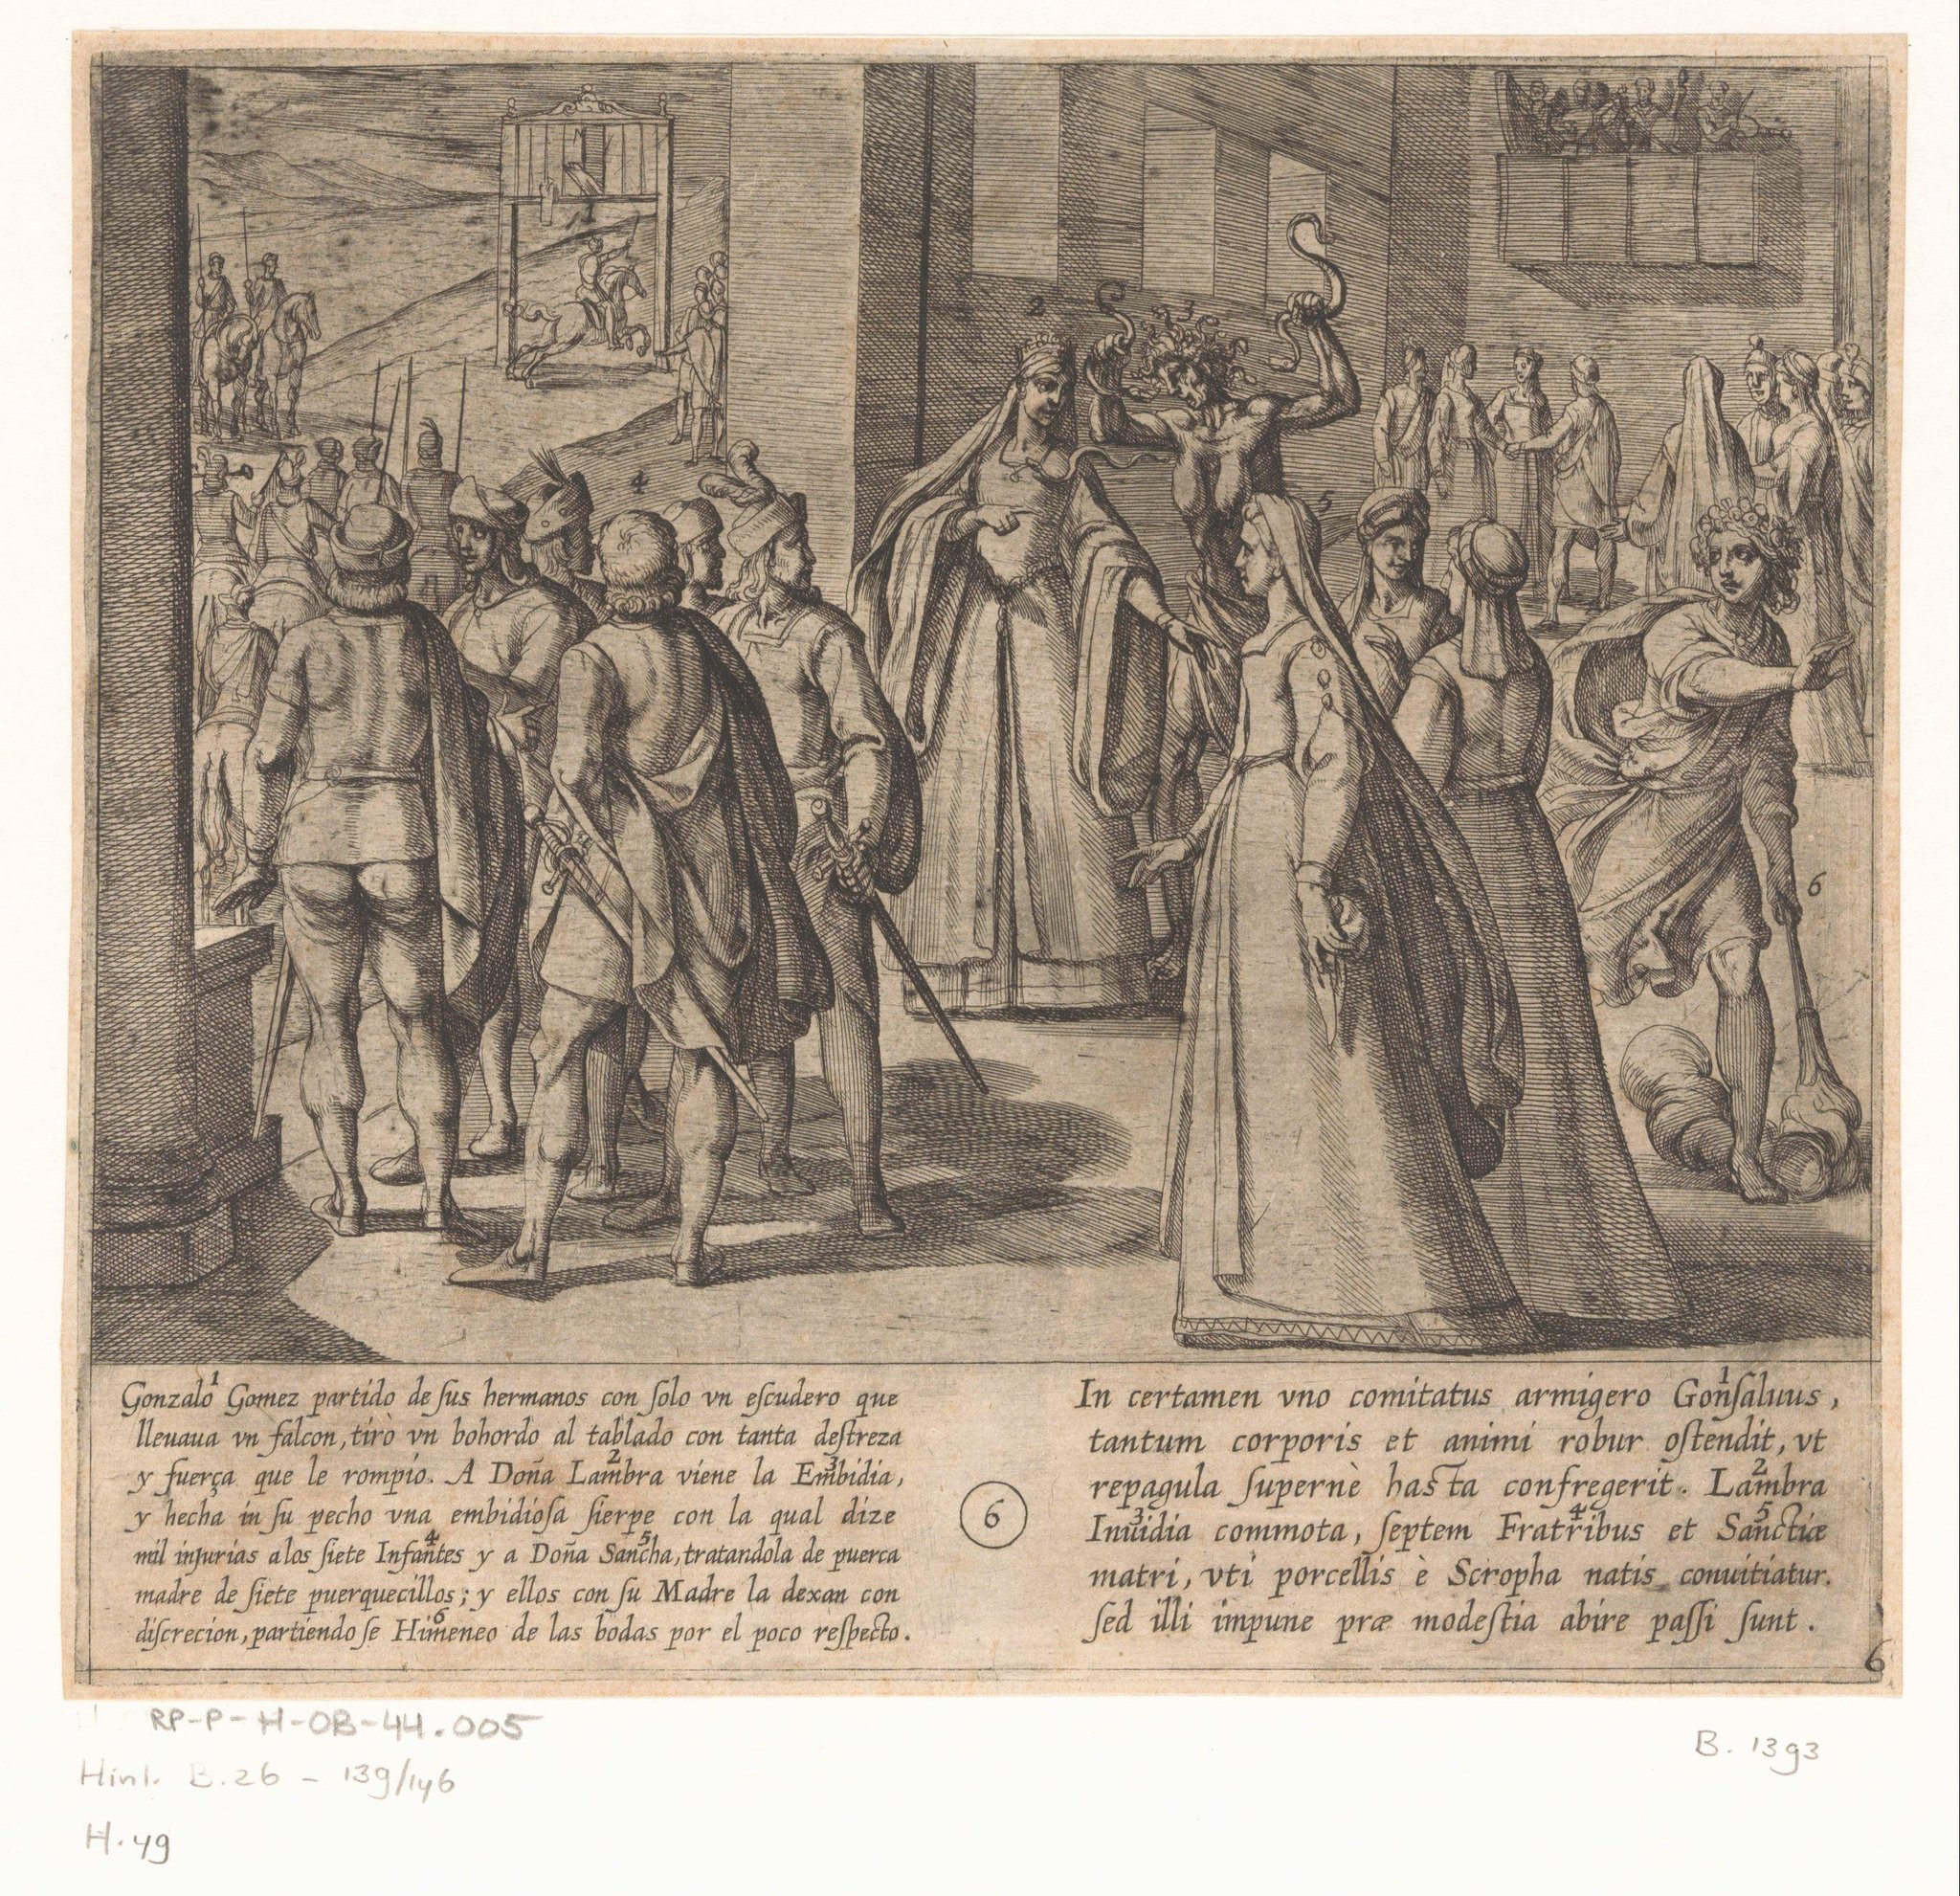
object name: print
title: Gonzalo Gomez blinkt uit in het spel en doña Lambra beledigt Lara en haar zonen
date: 1612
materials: paper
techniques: etching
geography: italy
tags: monsters of mixed human and animal shape; 'mostri' (ripa), palace, joust, tilt, tales and fairy tales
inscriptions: collector's mark: Lugt 11, collector's mark: ‘Hinloopen’, number: ‘6’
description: Deze prent maakt deel uit van een reeks van 40 prenten (+ titelprent) met voorstellingen uit het volksverhaal over de zeven infanten van Lara.